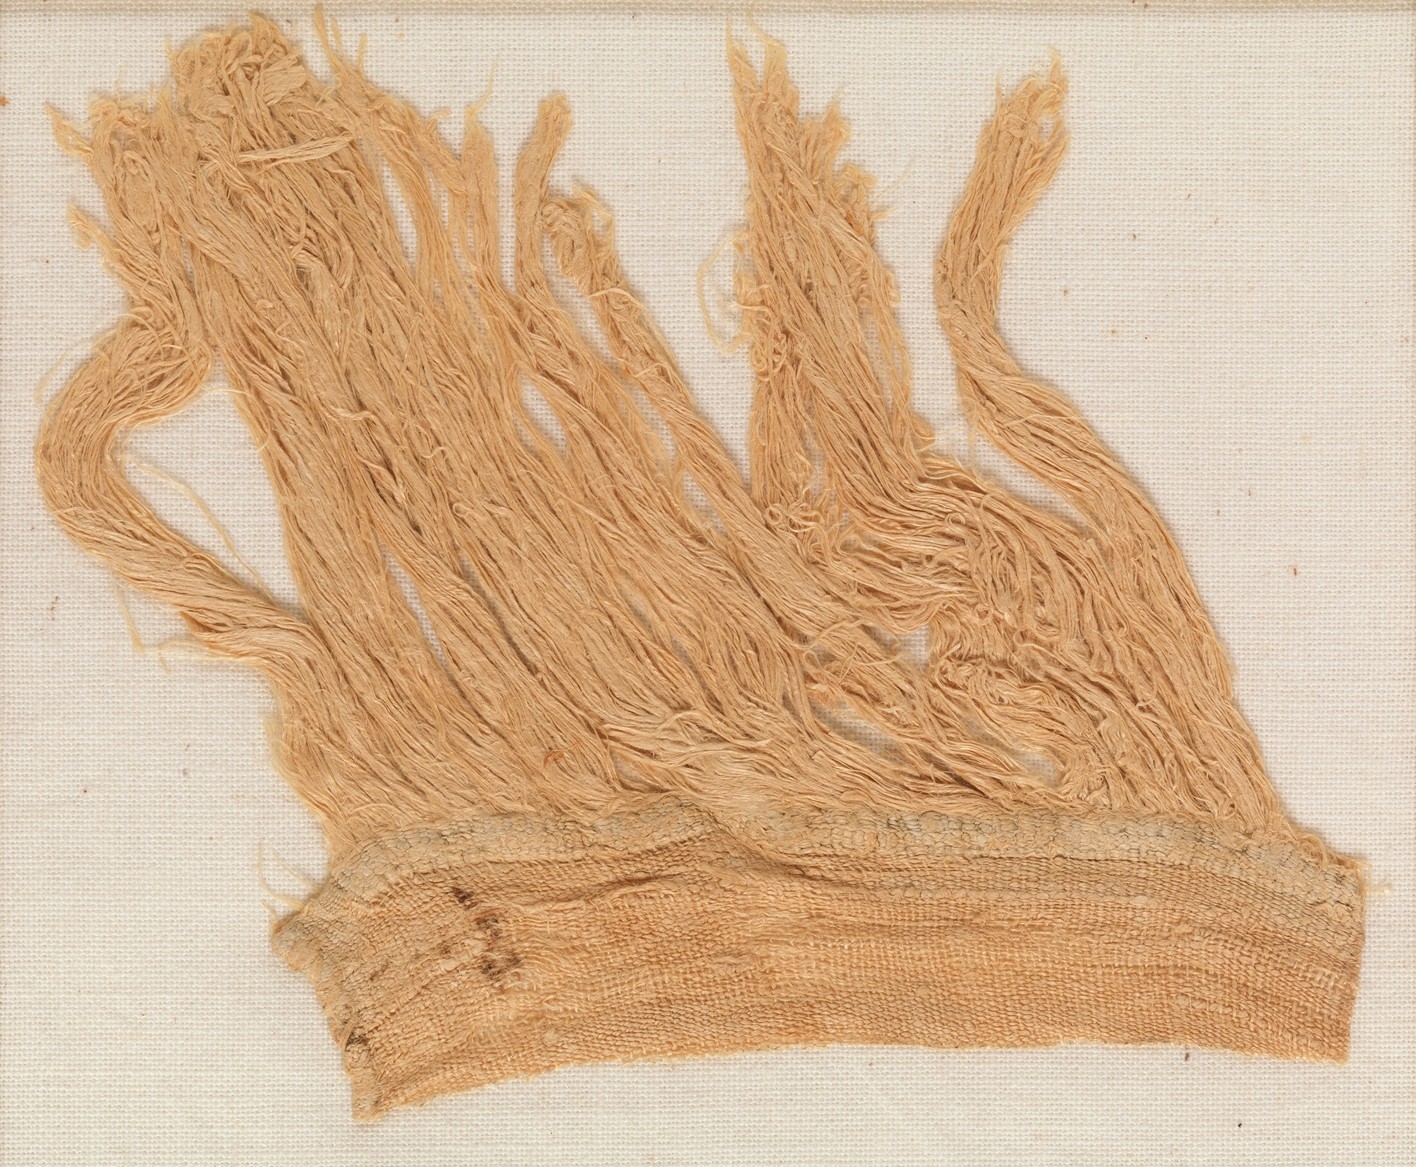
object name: linen mark, wah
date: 1981-1975 BCE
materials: linen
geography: egypt